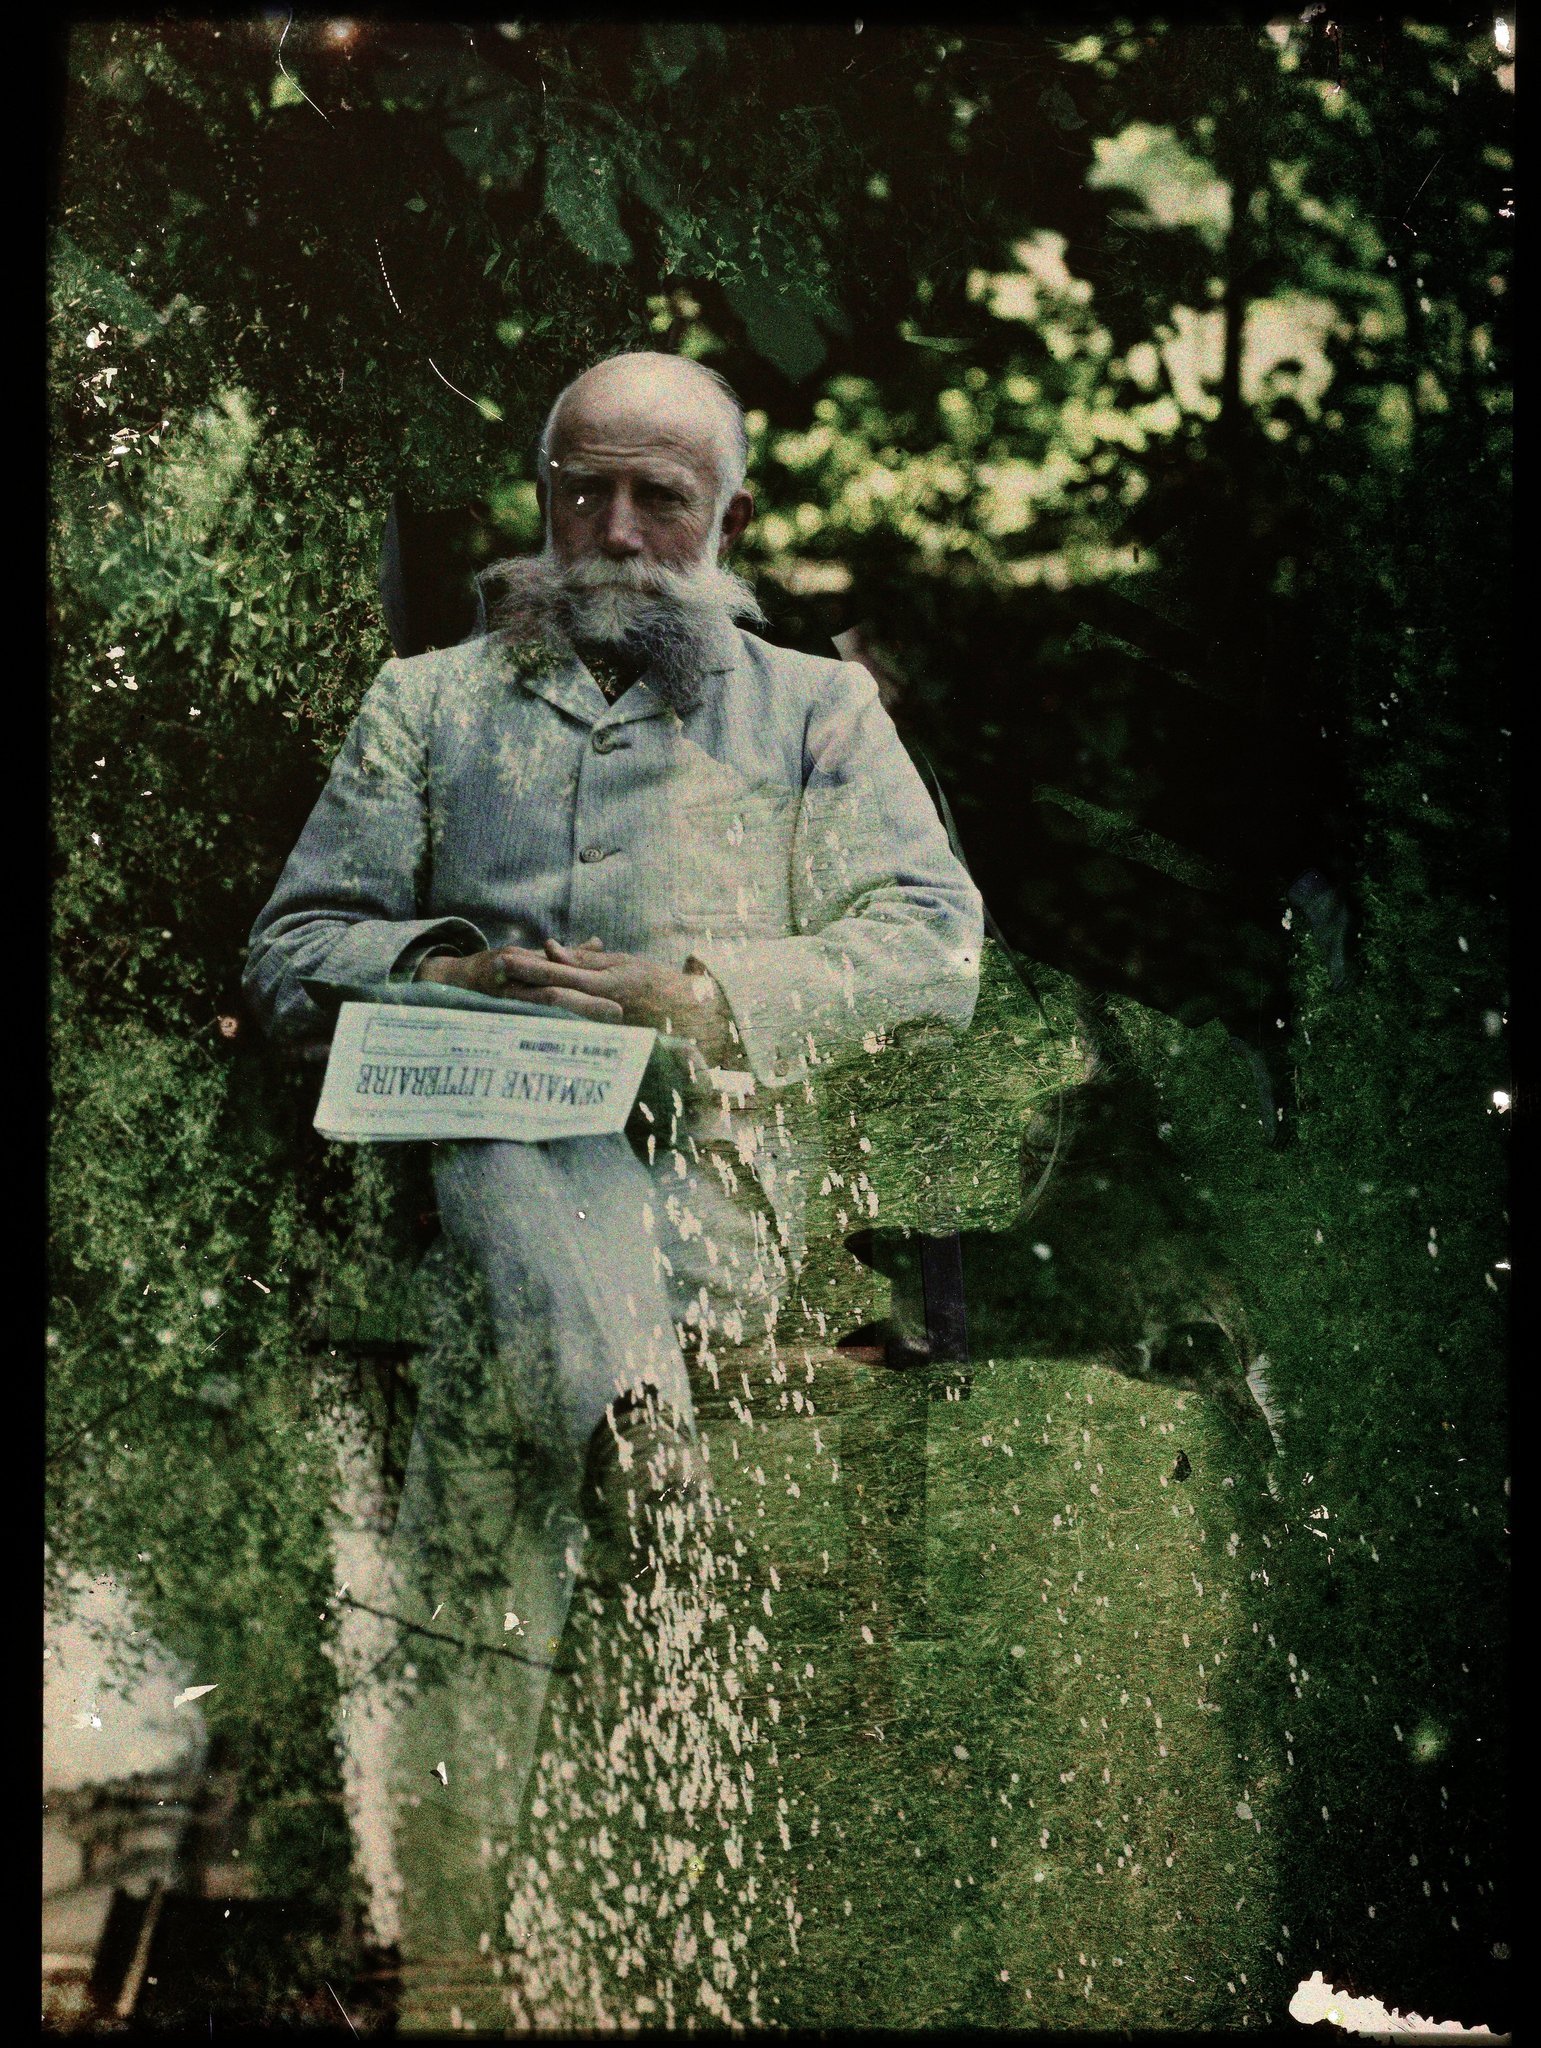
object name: color slide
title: Dubbeldruk van een zittende oude man op een grasveld en een hond, liggend in het gras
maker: adolphe burdet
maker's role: fotograaf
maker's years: 1860-1940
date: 1907-1930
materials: glass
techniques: autochrome process, slide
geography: netherlands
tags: adolphe burdet, dog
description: Dubbeldruk van een oude man met baard zittend in een stoel op een grasveld. Hij heeft een krant van het Semaine Littéraire op zijn schoot. En een opname van een hond, liggend in het gras.